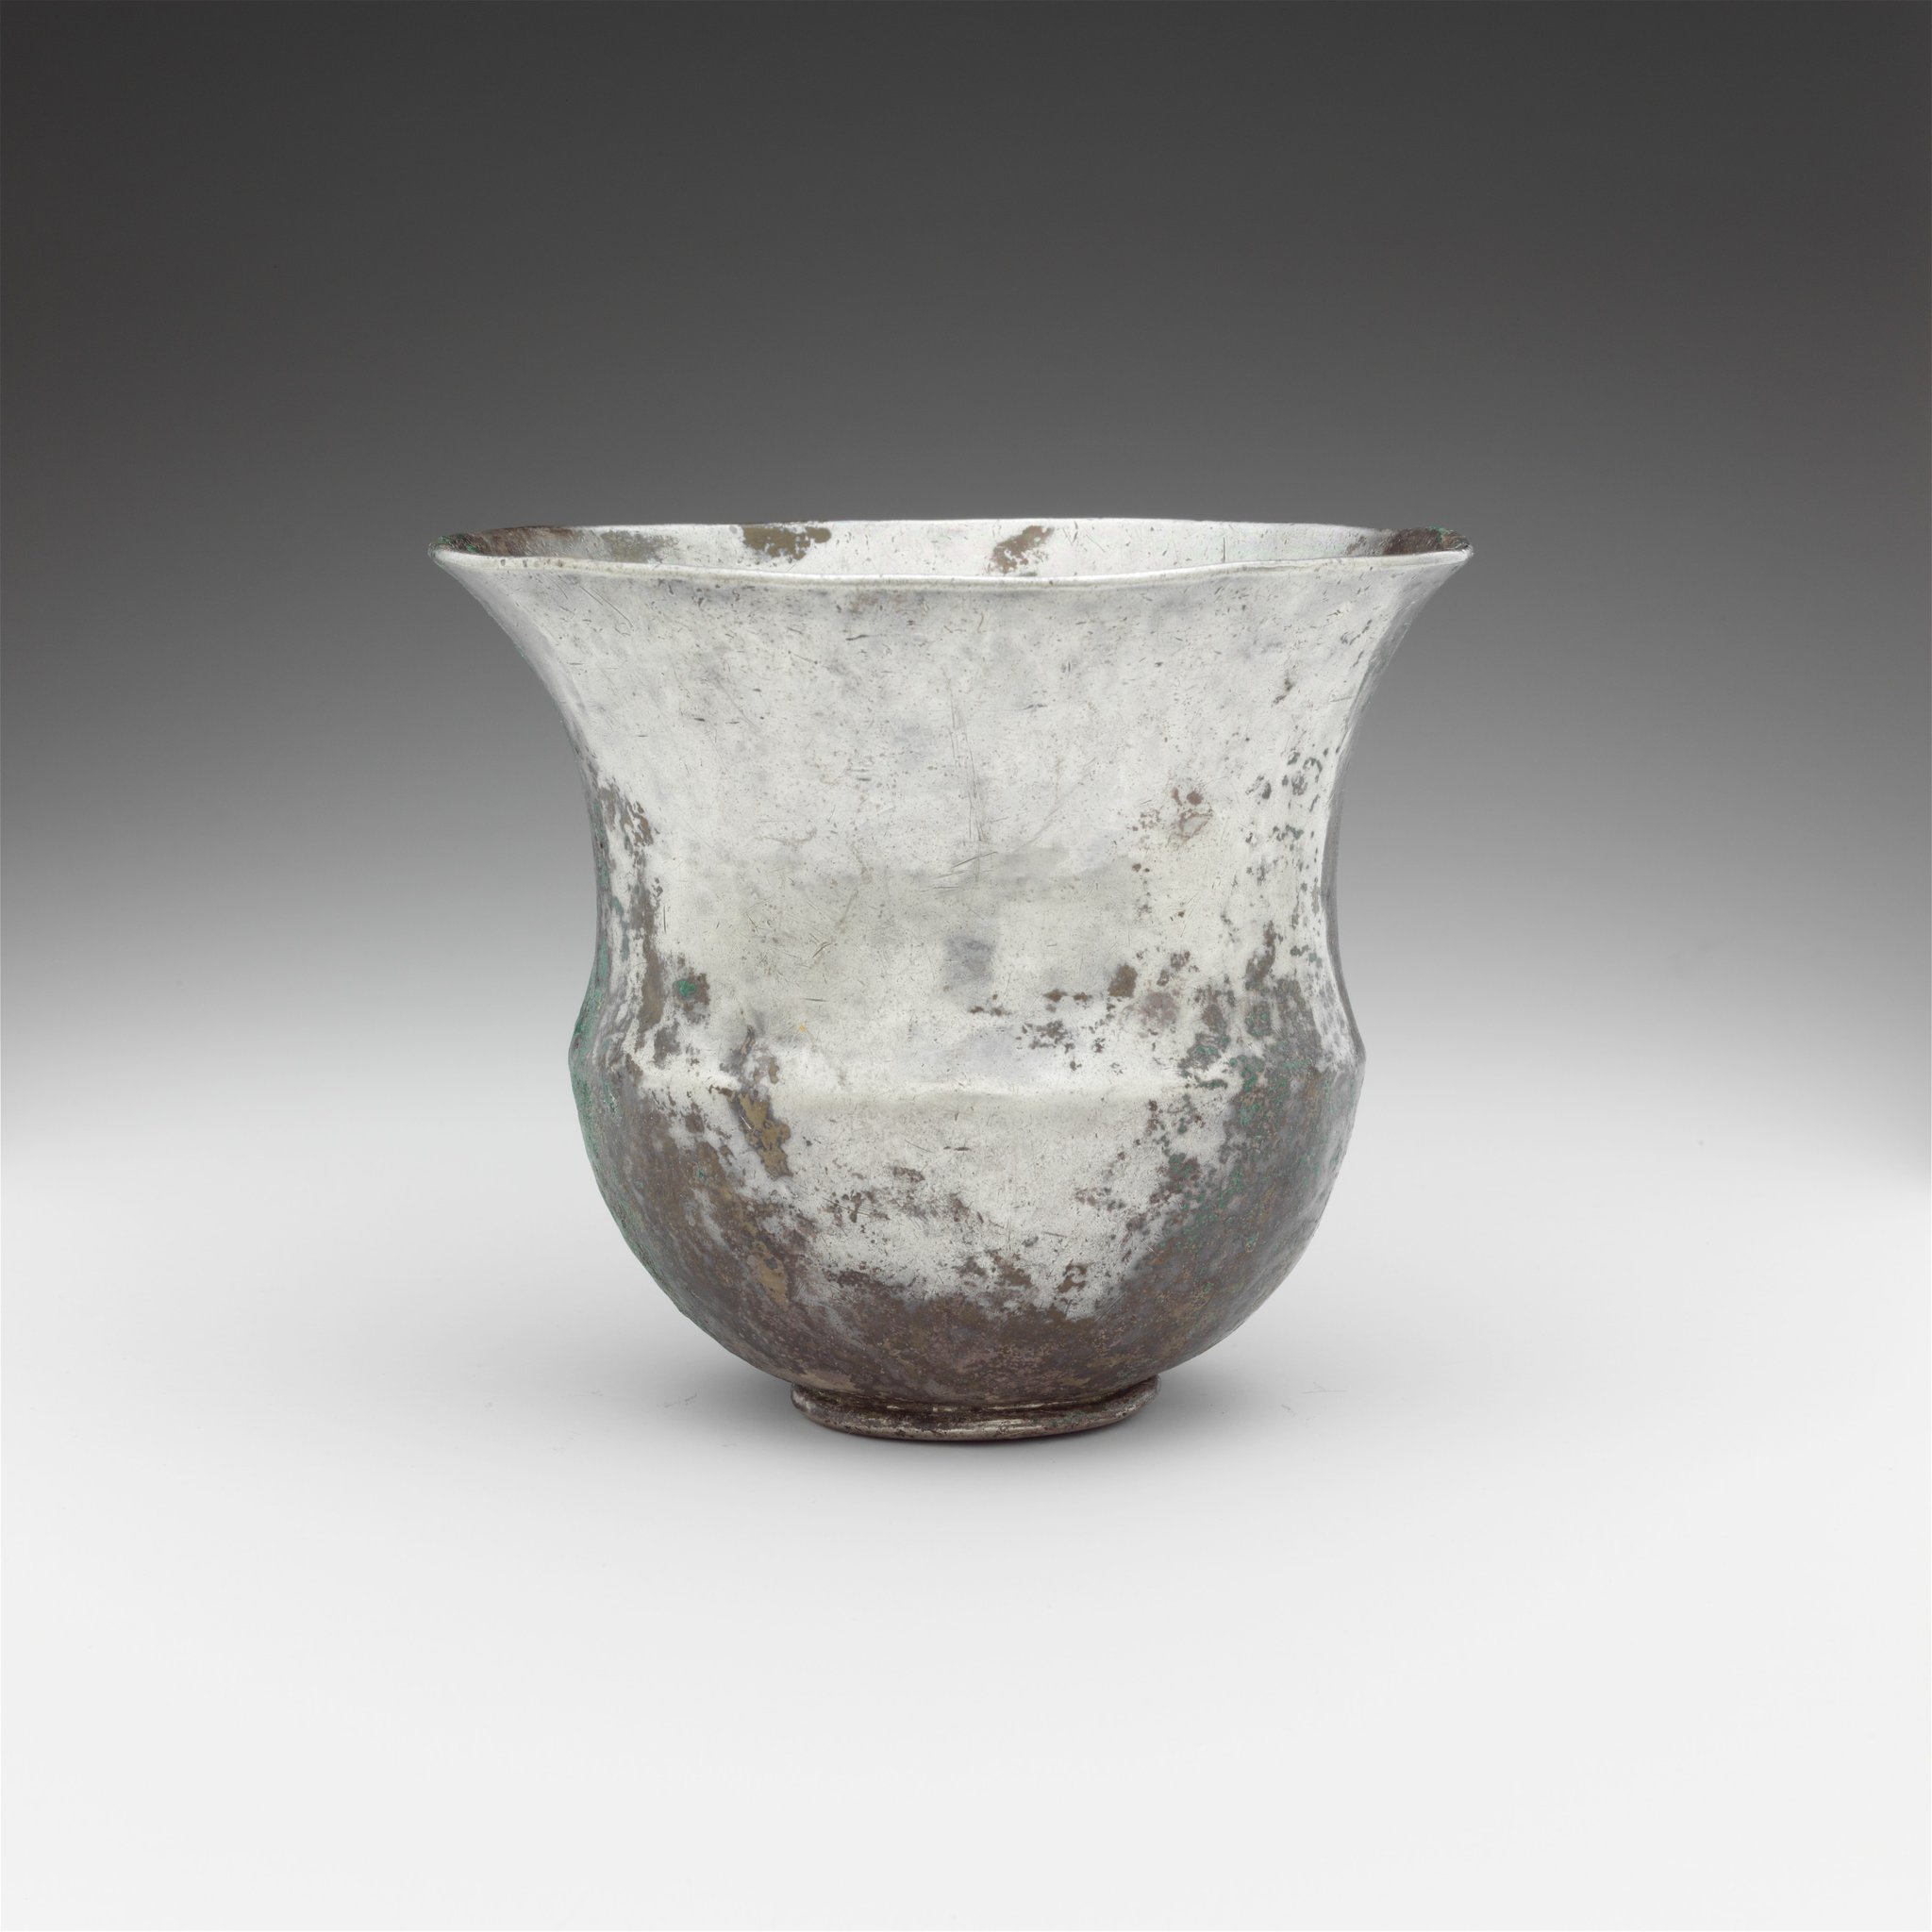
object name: beaker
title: Silver beaker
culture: anatolian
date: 2300-2000 BCE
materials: silver